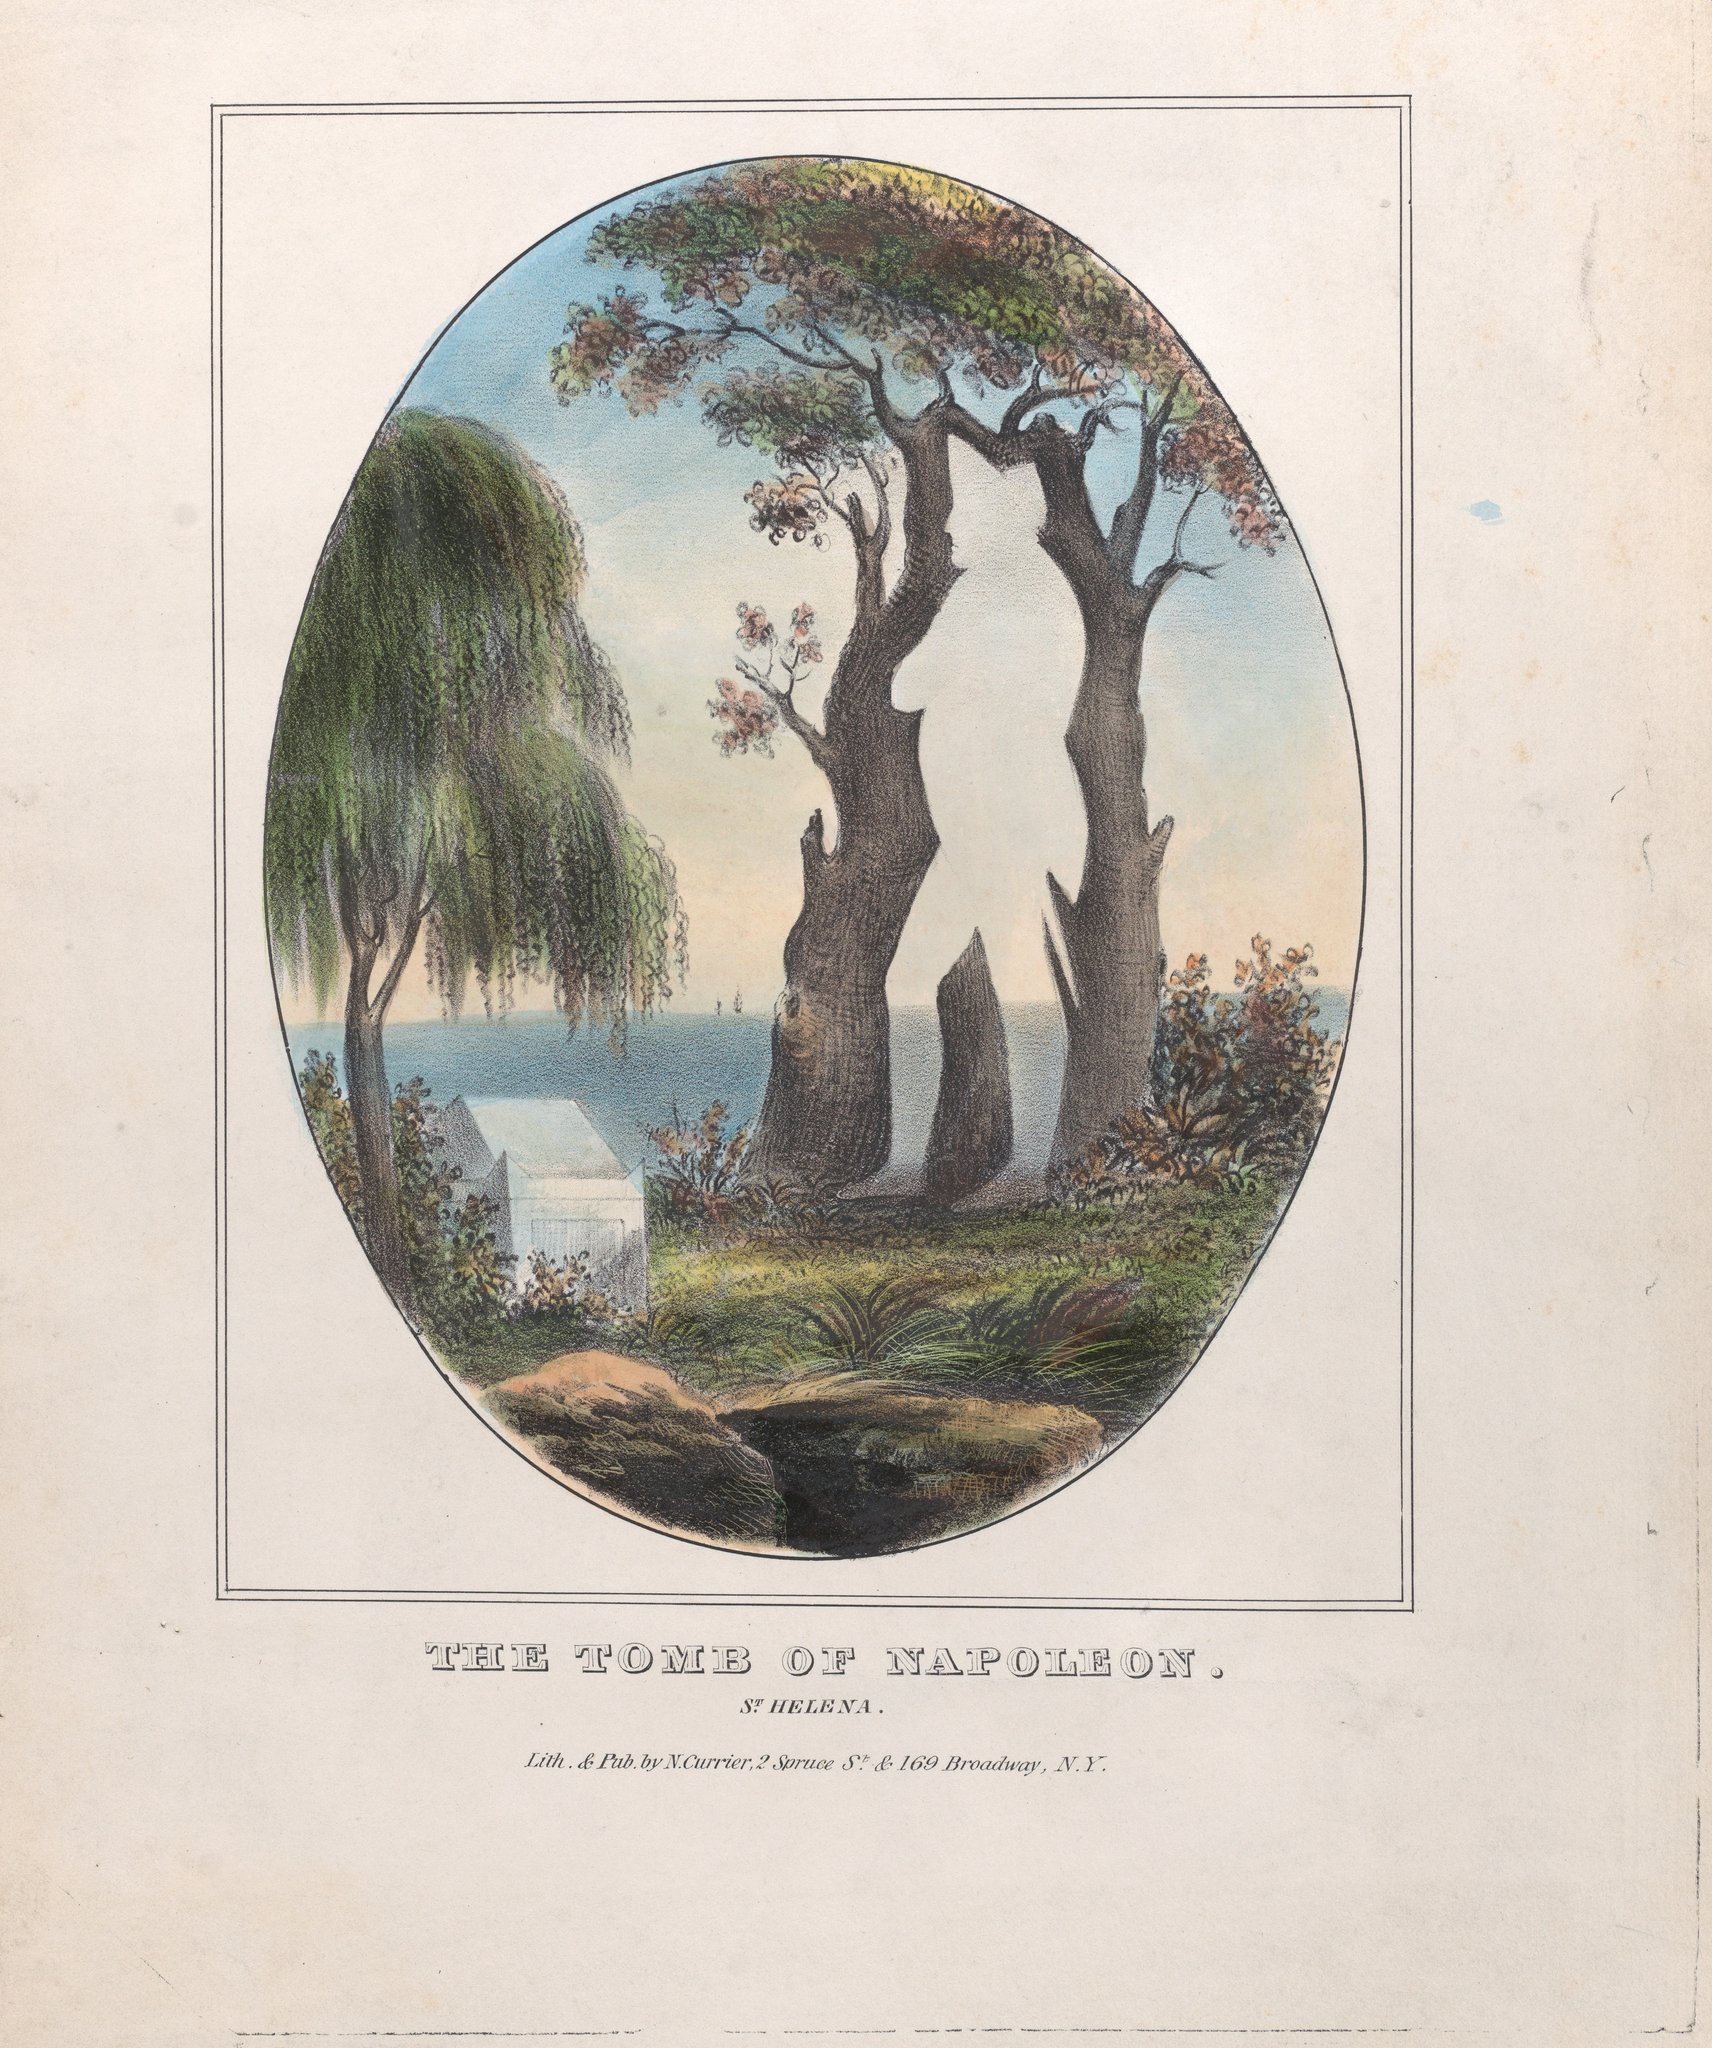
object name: print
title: The Tomb of Napoleon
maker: nathaniel currier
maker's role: artist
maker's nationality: american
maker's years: 1813-1888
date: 1842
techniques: lithograph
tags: tombs,napoleon i,trees